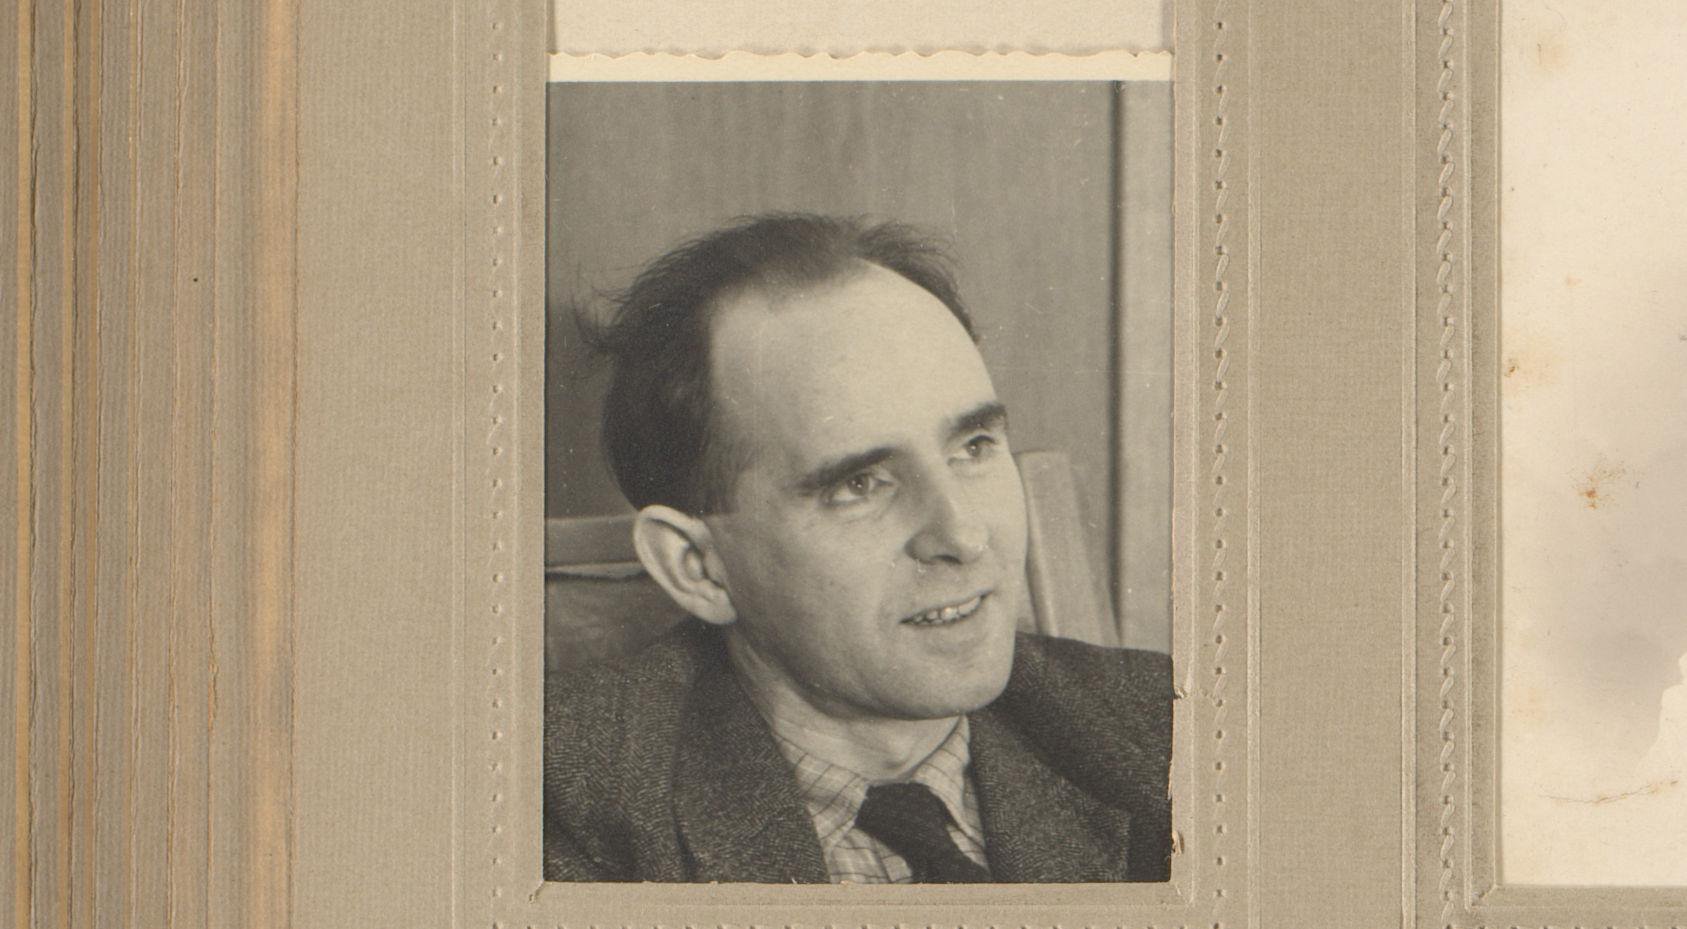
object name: photograph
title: Portret van een man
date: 1945-1960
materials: paper, photographic support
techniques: gelatin silver print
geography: netherlands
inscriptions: title: ‘G.A. de Lange, geb. 11 november 1904, gedoopt 18 juni 1905 genomen maart 1906’